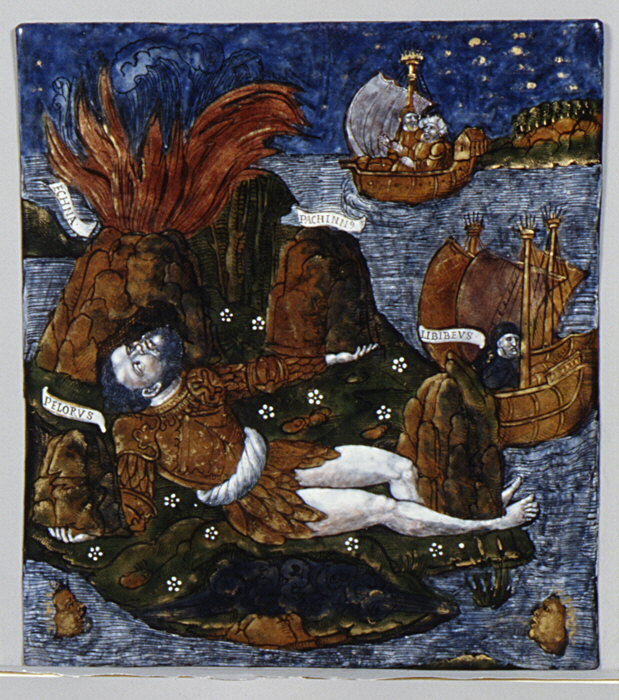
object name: plaque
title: Trojans Land Near Mount Etna; Beneath Lies the Giant Enceladus (Aeneid, Book III)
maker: master of the aeneid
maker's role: artist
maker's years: 1525-1545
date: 1530-1535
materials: copper, enamel, gilt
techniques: painting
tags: men,volcanoes,boats